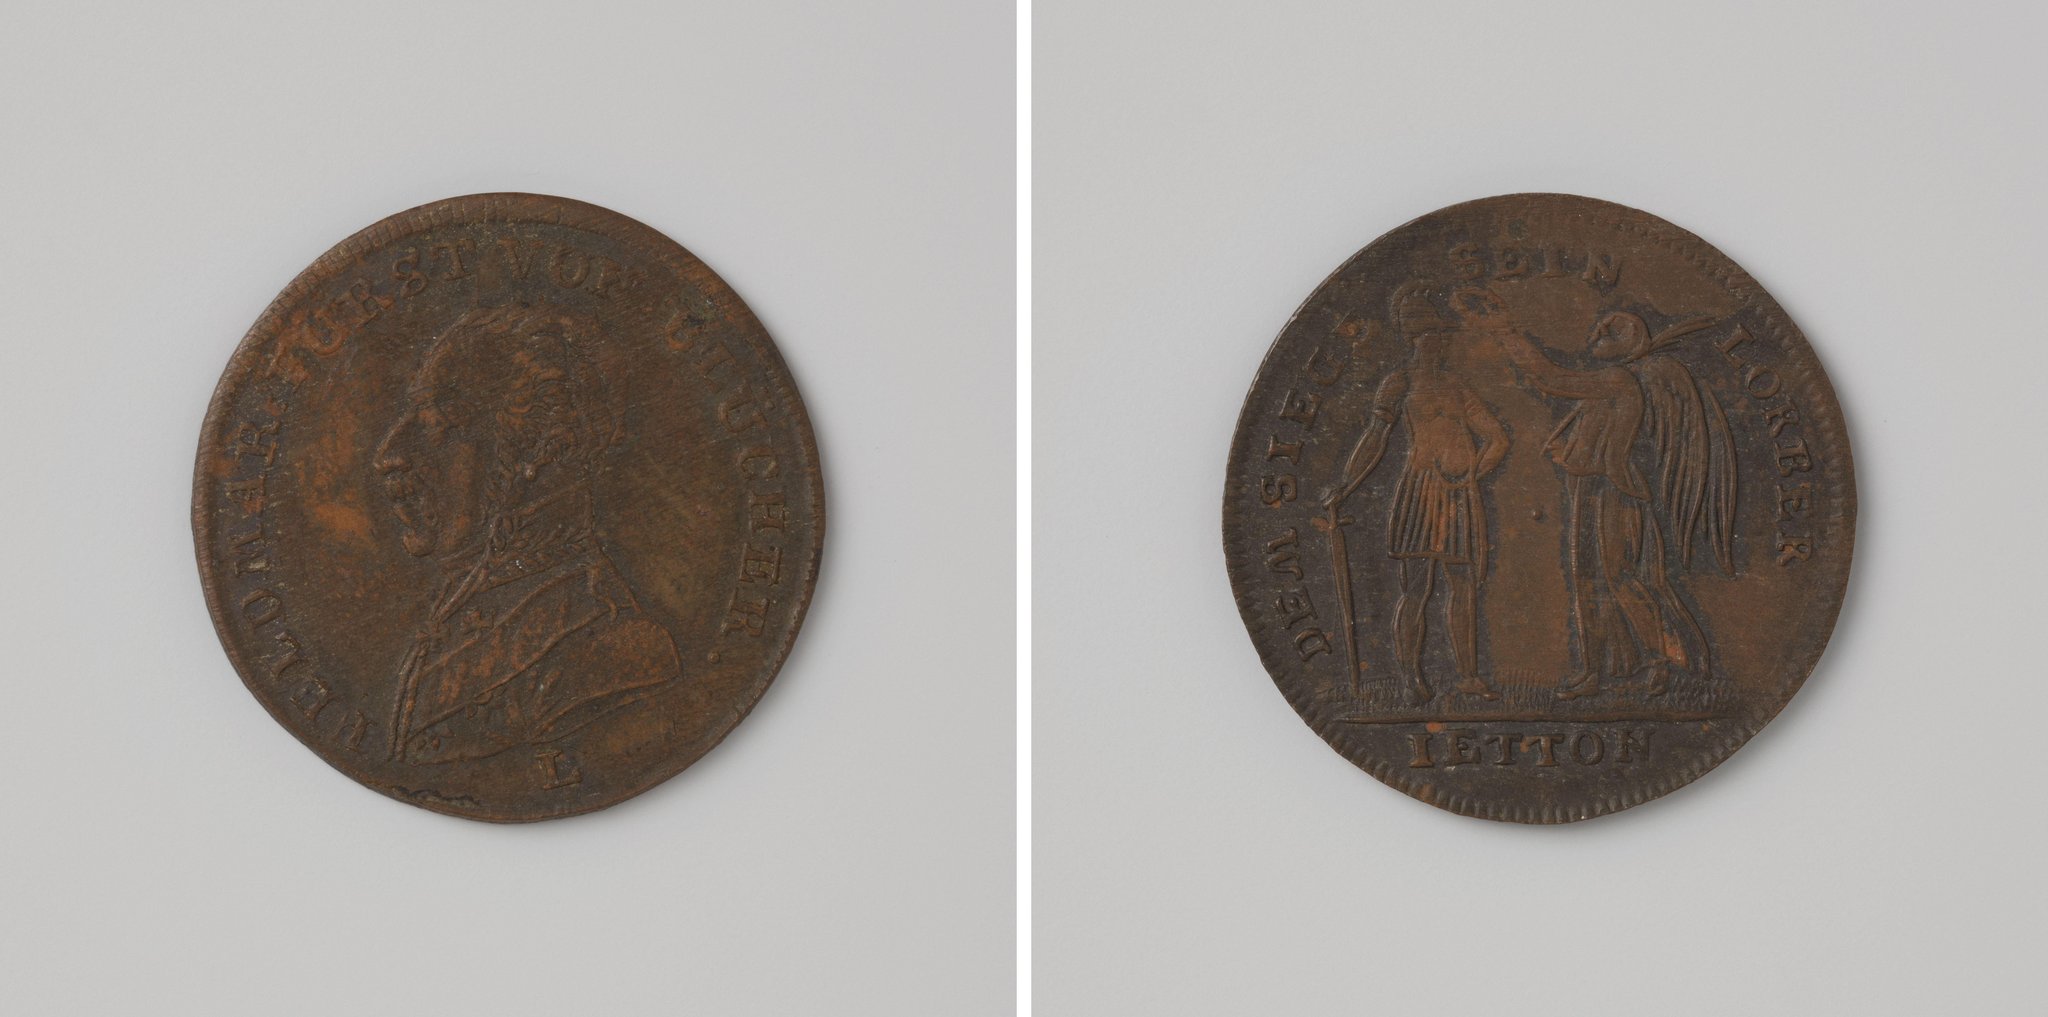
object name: jeton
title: Gebhard Leberecht von Blucher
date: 1813-1815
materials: copper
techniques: striking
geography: nuremberg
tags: rostock, generaal, gebhard leberecht von blücher von wahlstatt, napoleontische oorlogen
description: Koperen penning. Voorzijde: borststuk man binnen omschrift. Keerzijde: gevleugelde Overwinning houdt Blucher, die op zijn zwaard leunt lauwerkrans boven hoofd binnen omschrift; afsnede: opschrift